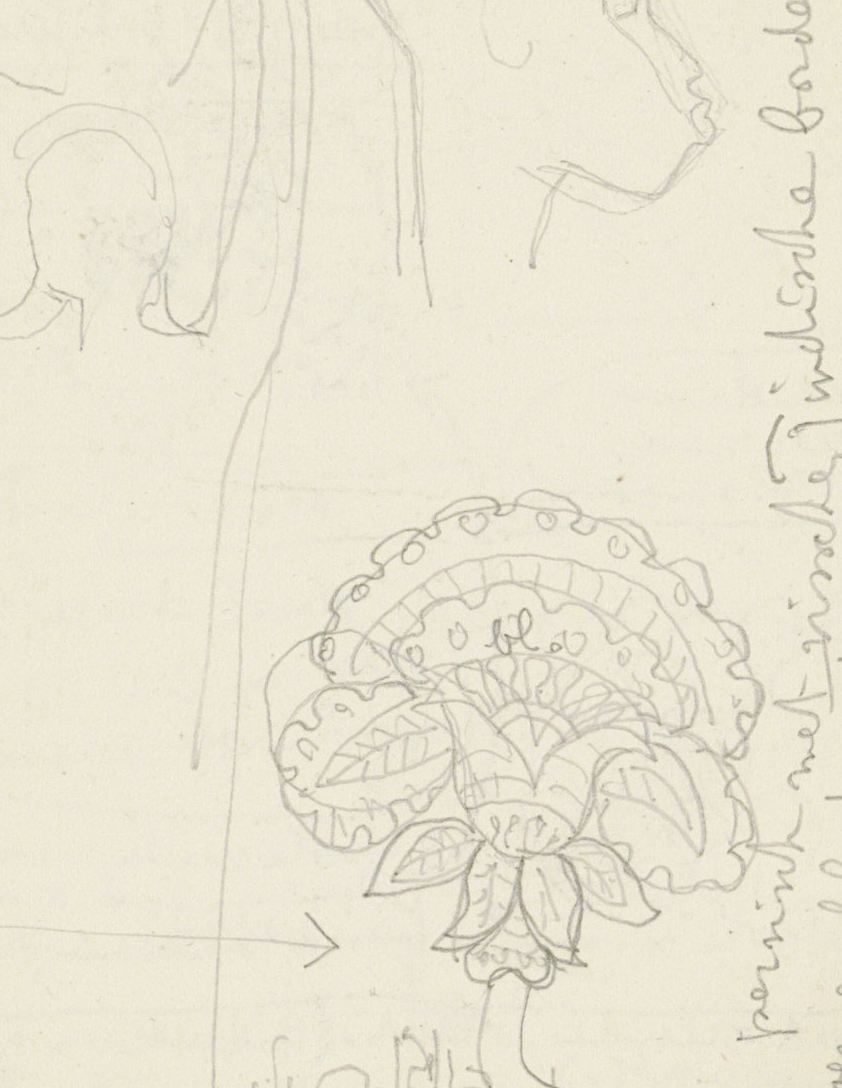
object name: sketchbook leaf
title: Bloem en een Afrikaanse vrouw die een kruik op het hoofd draagt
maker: reijer stolk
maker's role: draughtsman, print maker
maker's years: 1896-1945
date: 1916-1945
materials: paper, pencil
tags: flowers, africans, carrying something on the head or on the shoulders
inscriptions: kleurnotitie, handgeschreven in potlood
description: Tevens studies van het hoofd van een Afrikaan en decoratieve patronen. Blad 32 verso uit een schetsboek met 60 bladen.